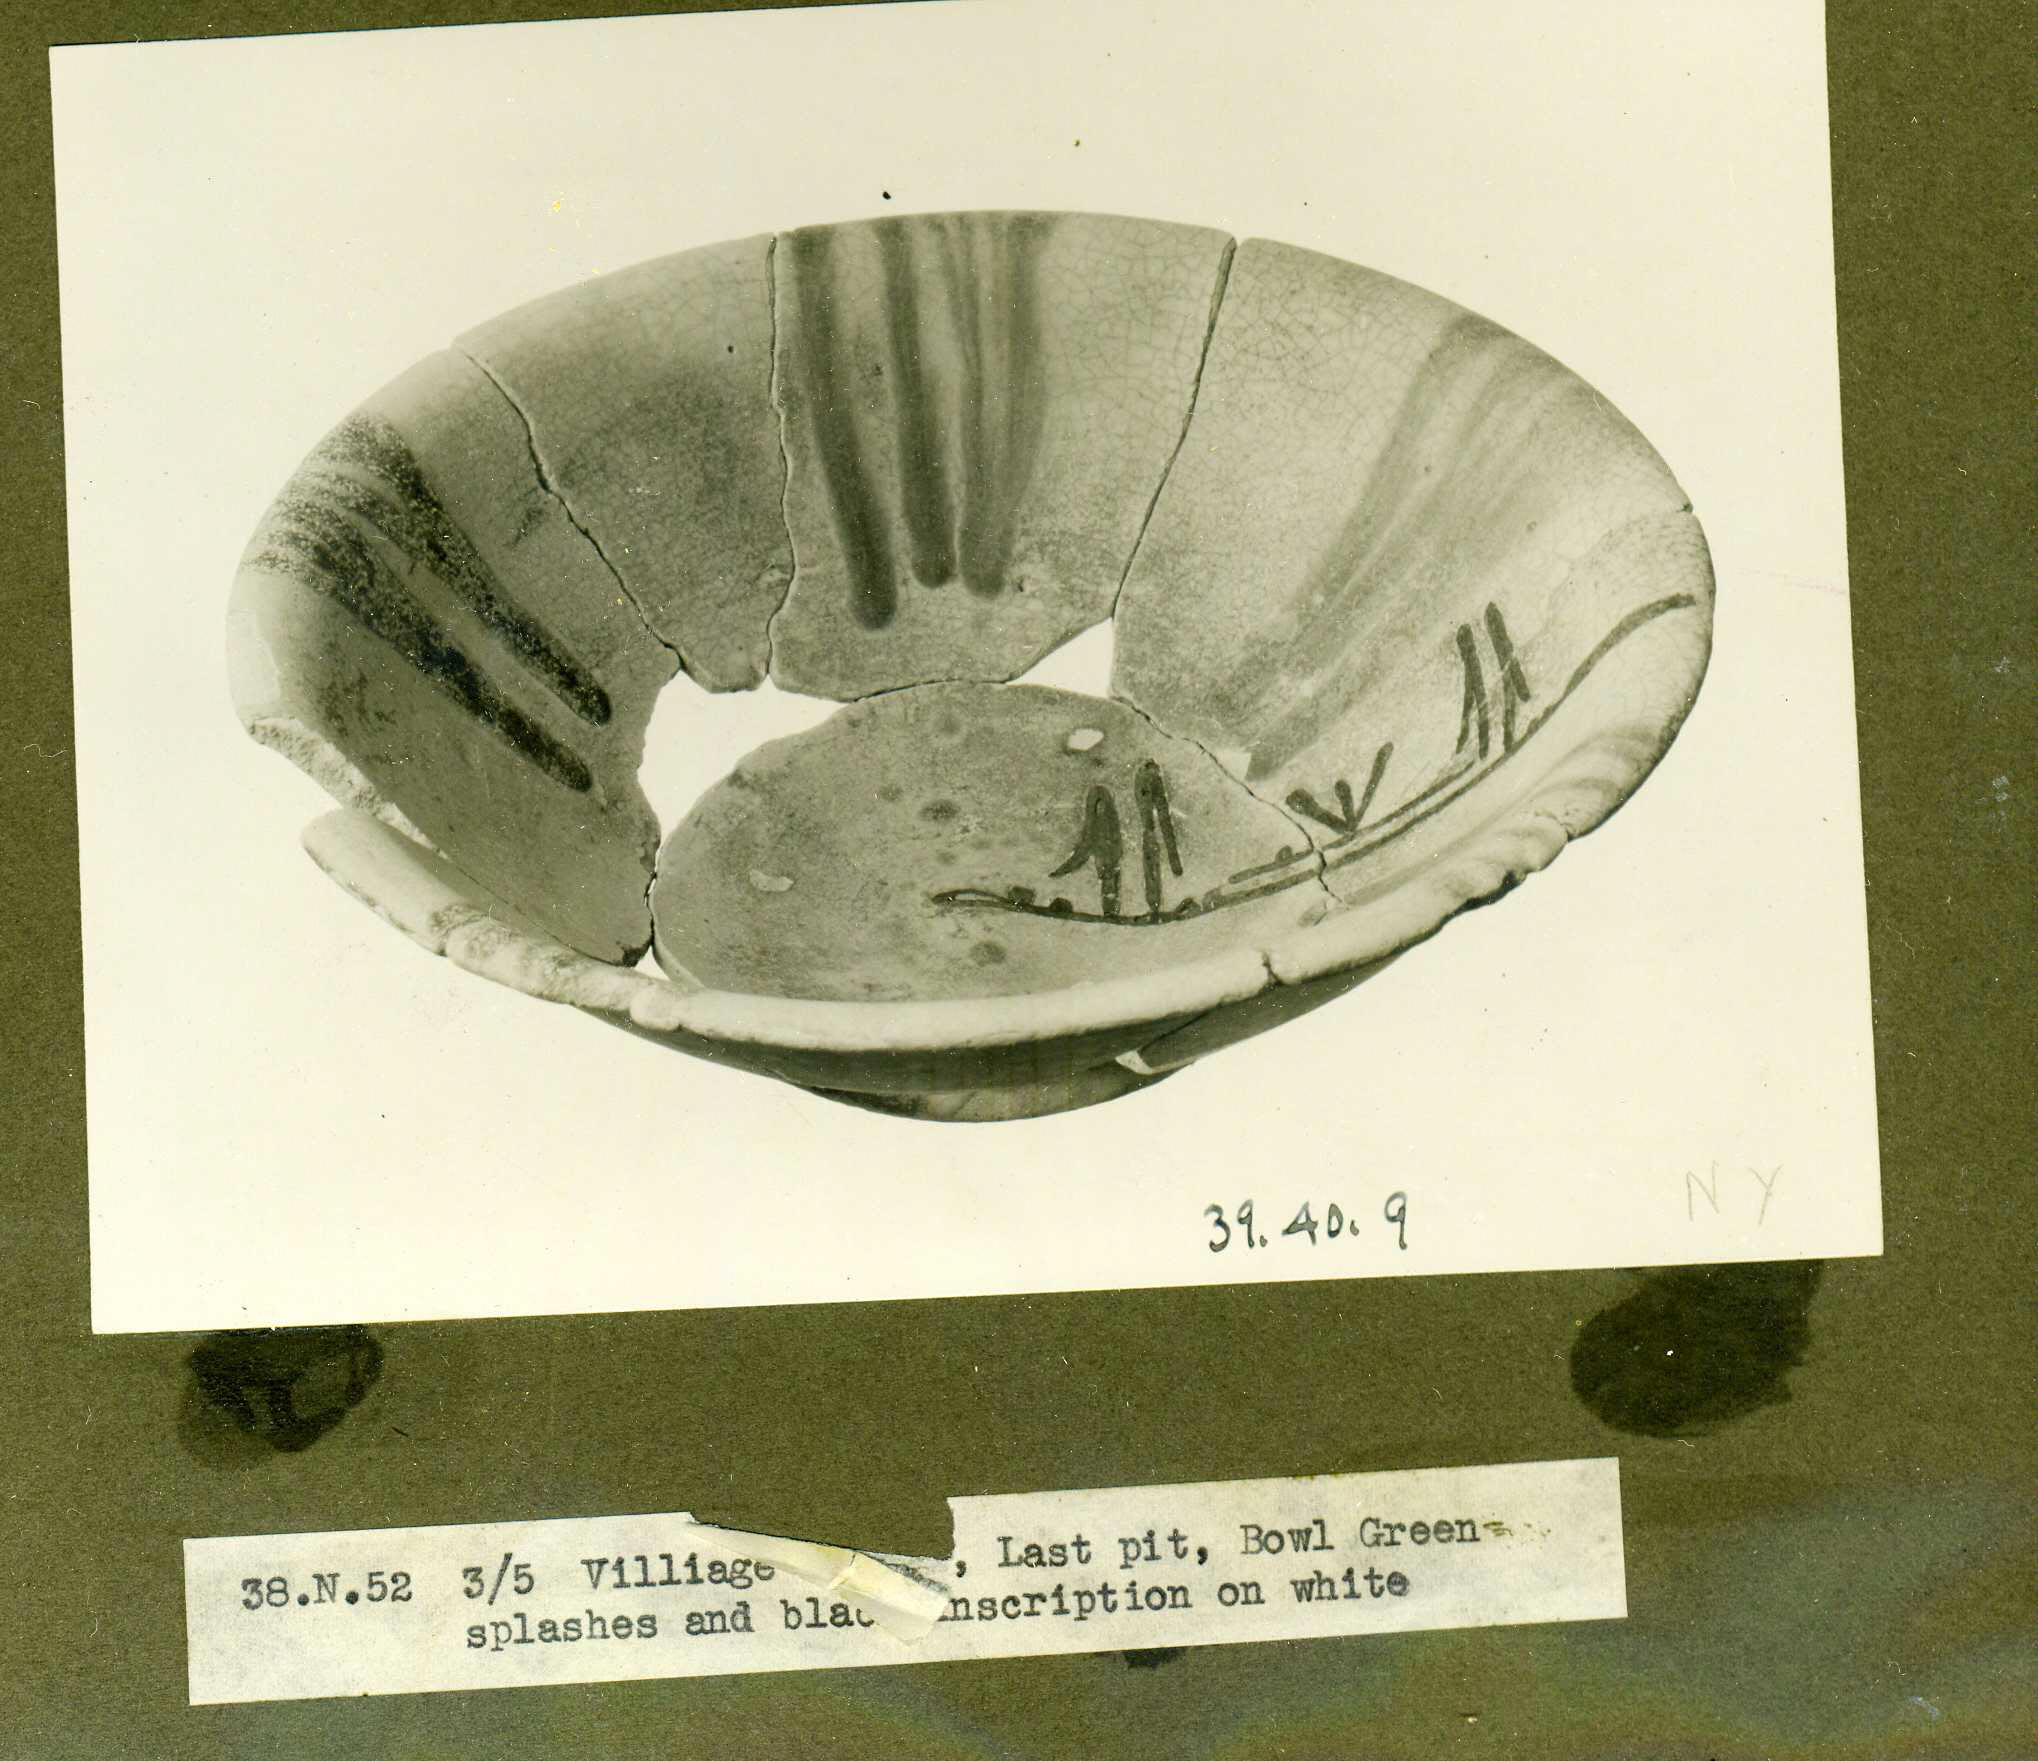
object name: bowl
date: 701-900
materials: earthenware, glaze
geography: iran